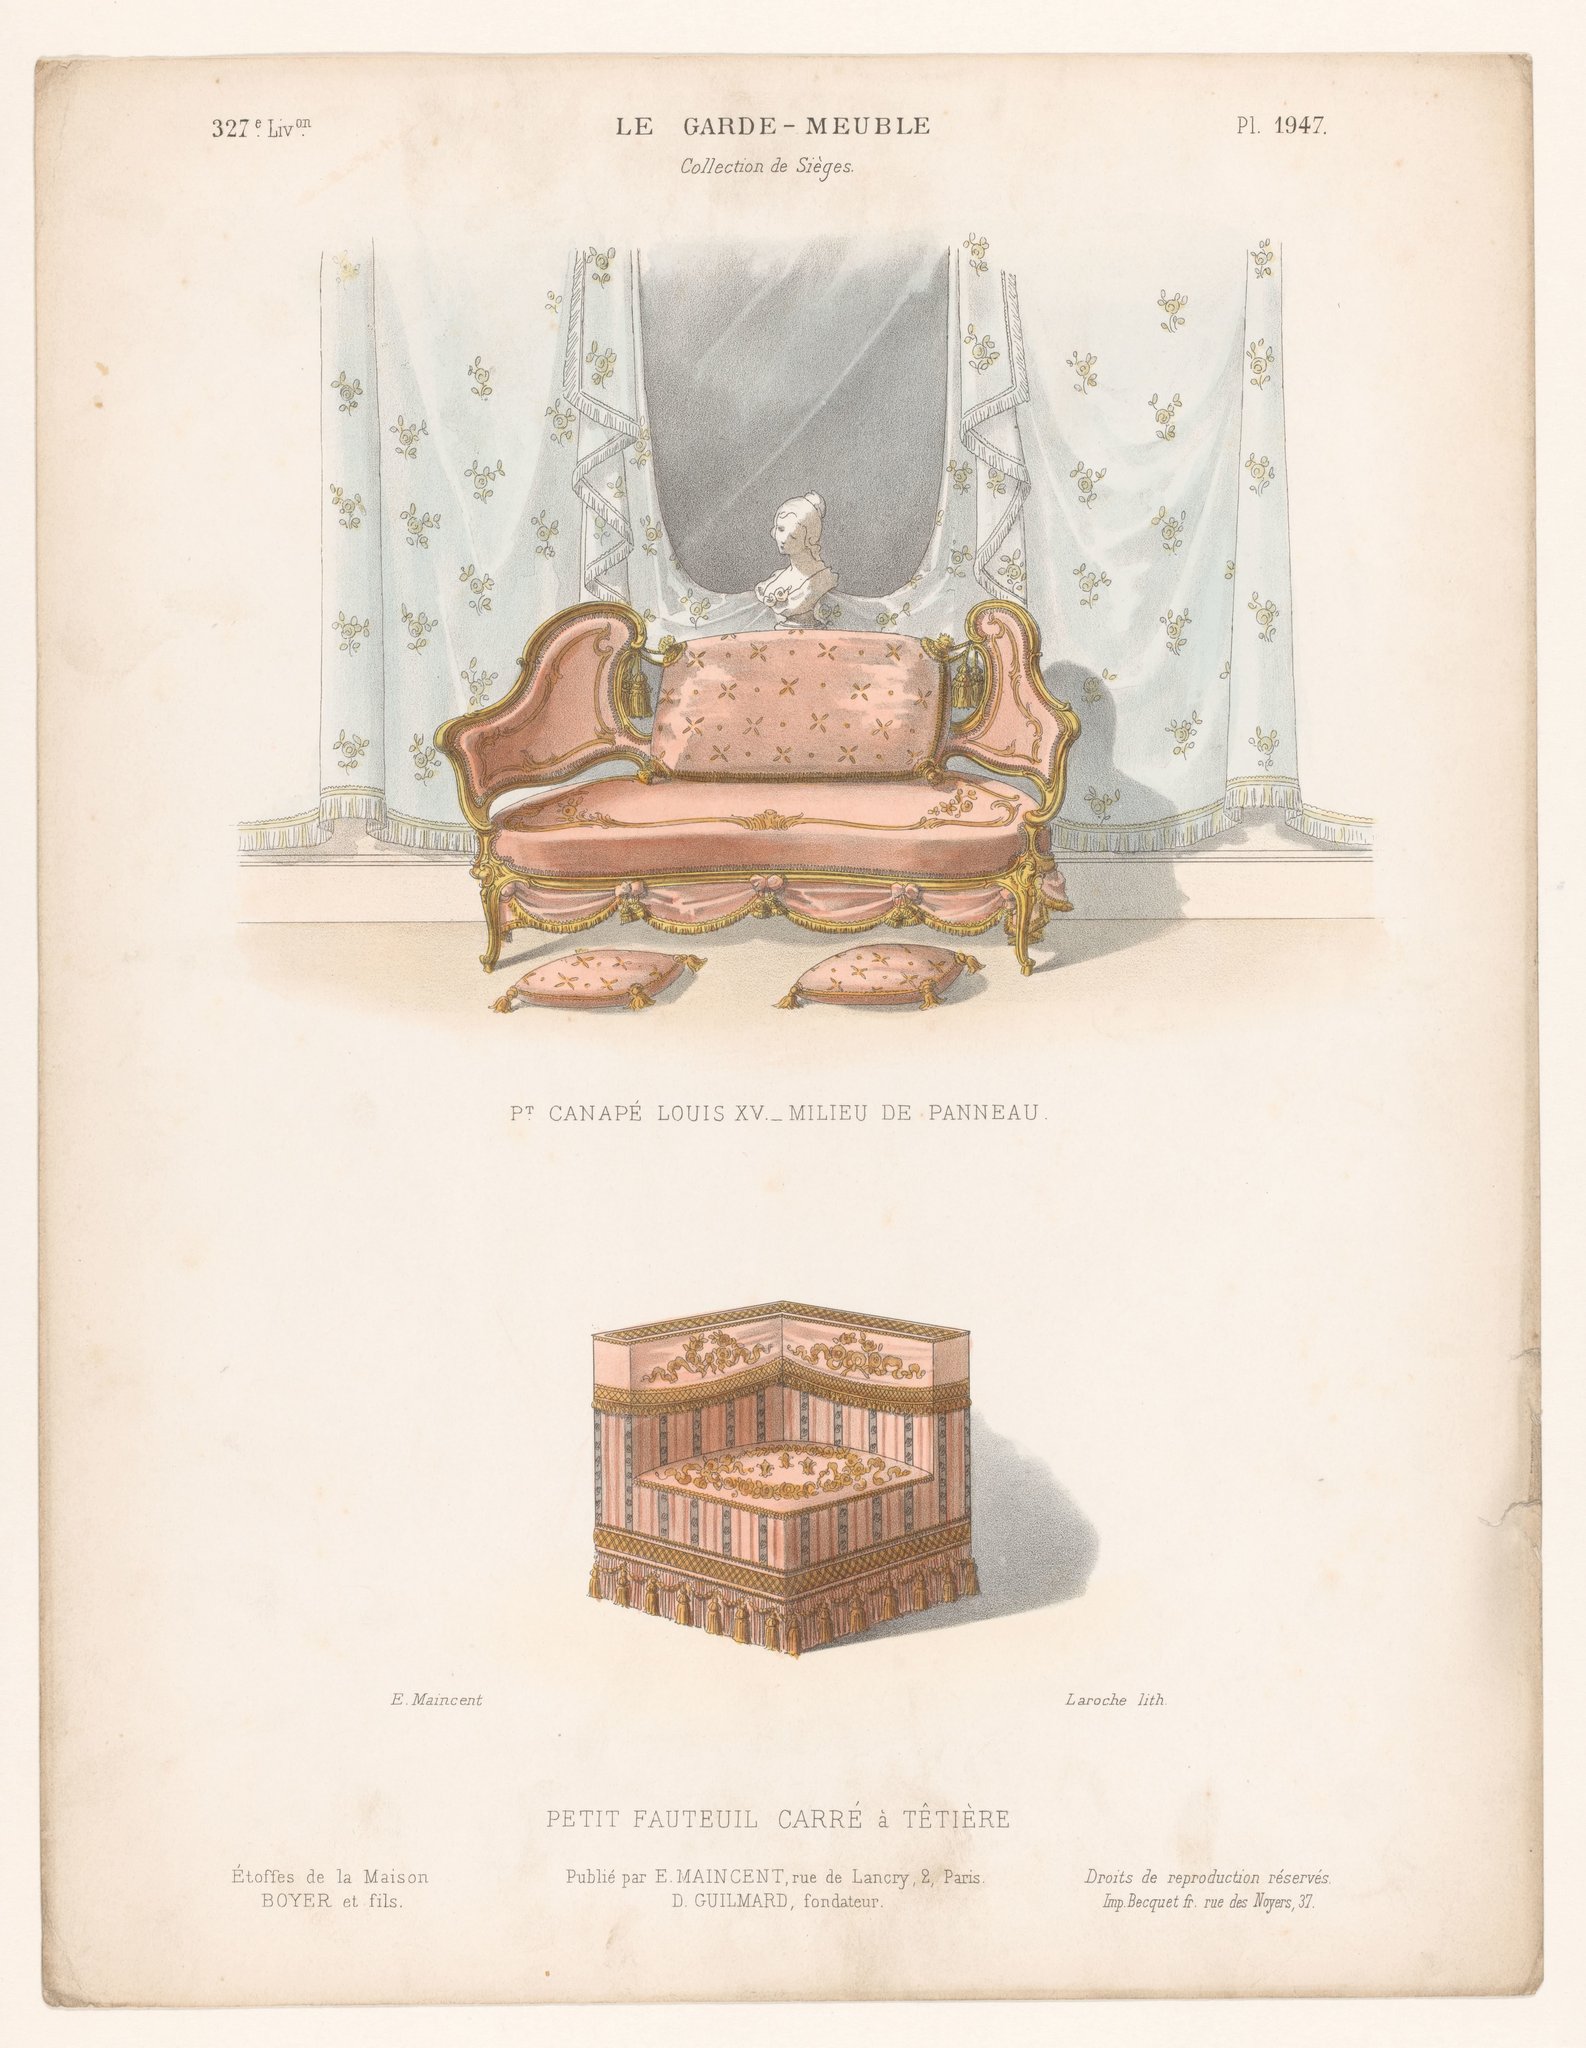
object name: print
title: Pt. canapé Louis XV Milieu de panneau / Petit fauteuil carré à têtière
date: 1885-1895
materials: paper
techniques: hand coloring, lithograph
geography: paris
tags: seating furniture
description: Ieder Livraison in de serie Le Garde-Meuble bevat negen platen: drie 'sièges' (zitmeubels), drie 'meubles' (diverse meubels zoals tafels en kasten) en drie 'tentures' (gordijnen en draperieën).